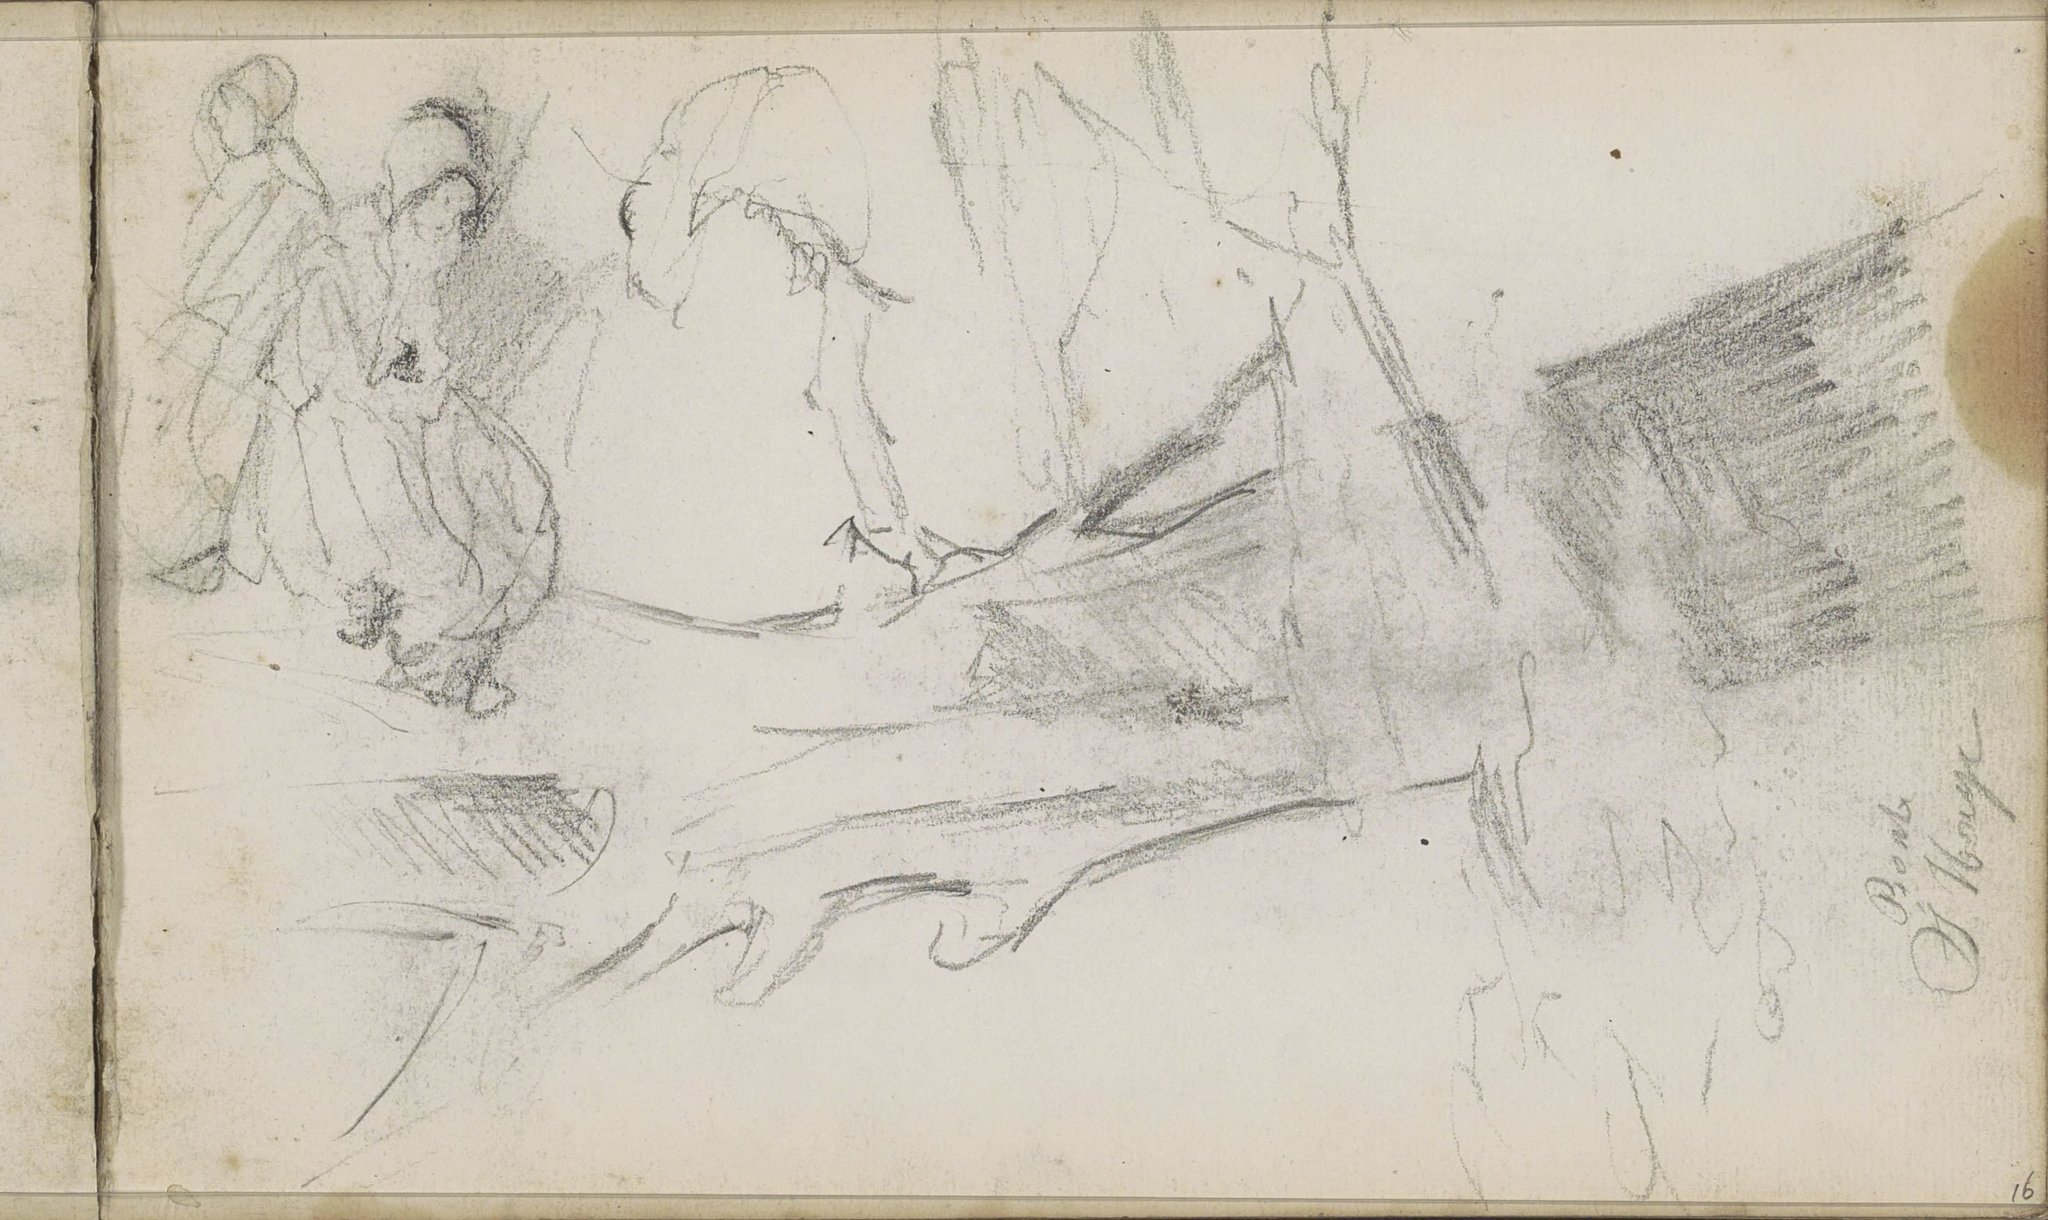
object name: sketchbook leaf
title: Boom en figuren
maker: willem cornelis rip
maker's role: draughtsman, painter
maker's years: 1856-1922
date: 1876-1877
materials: paper, pencil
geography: the hague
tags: trees, anatomy (non-medical)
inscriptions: annotation: ‘[...]ont/ 's Hage’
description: Blad 16 recto uit een schetsboek met 41 bladen.